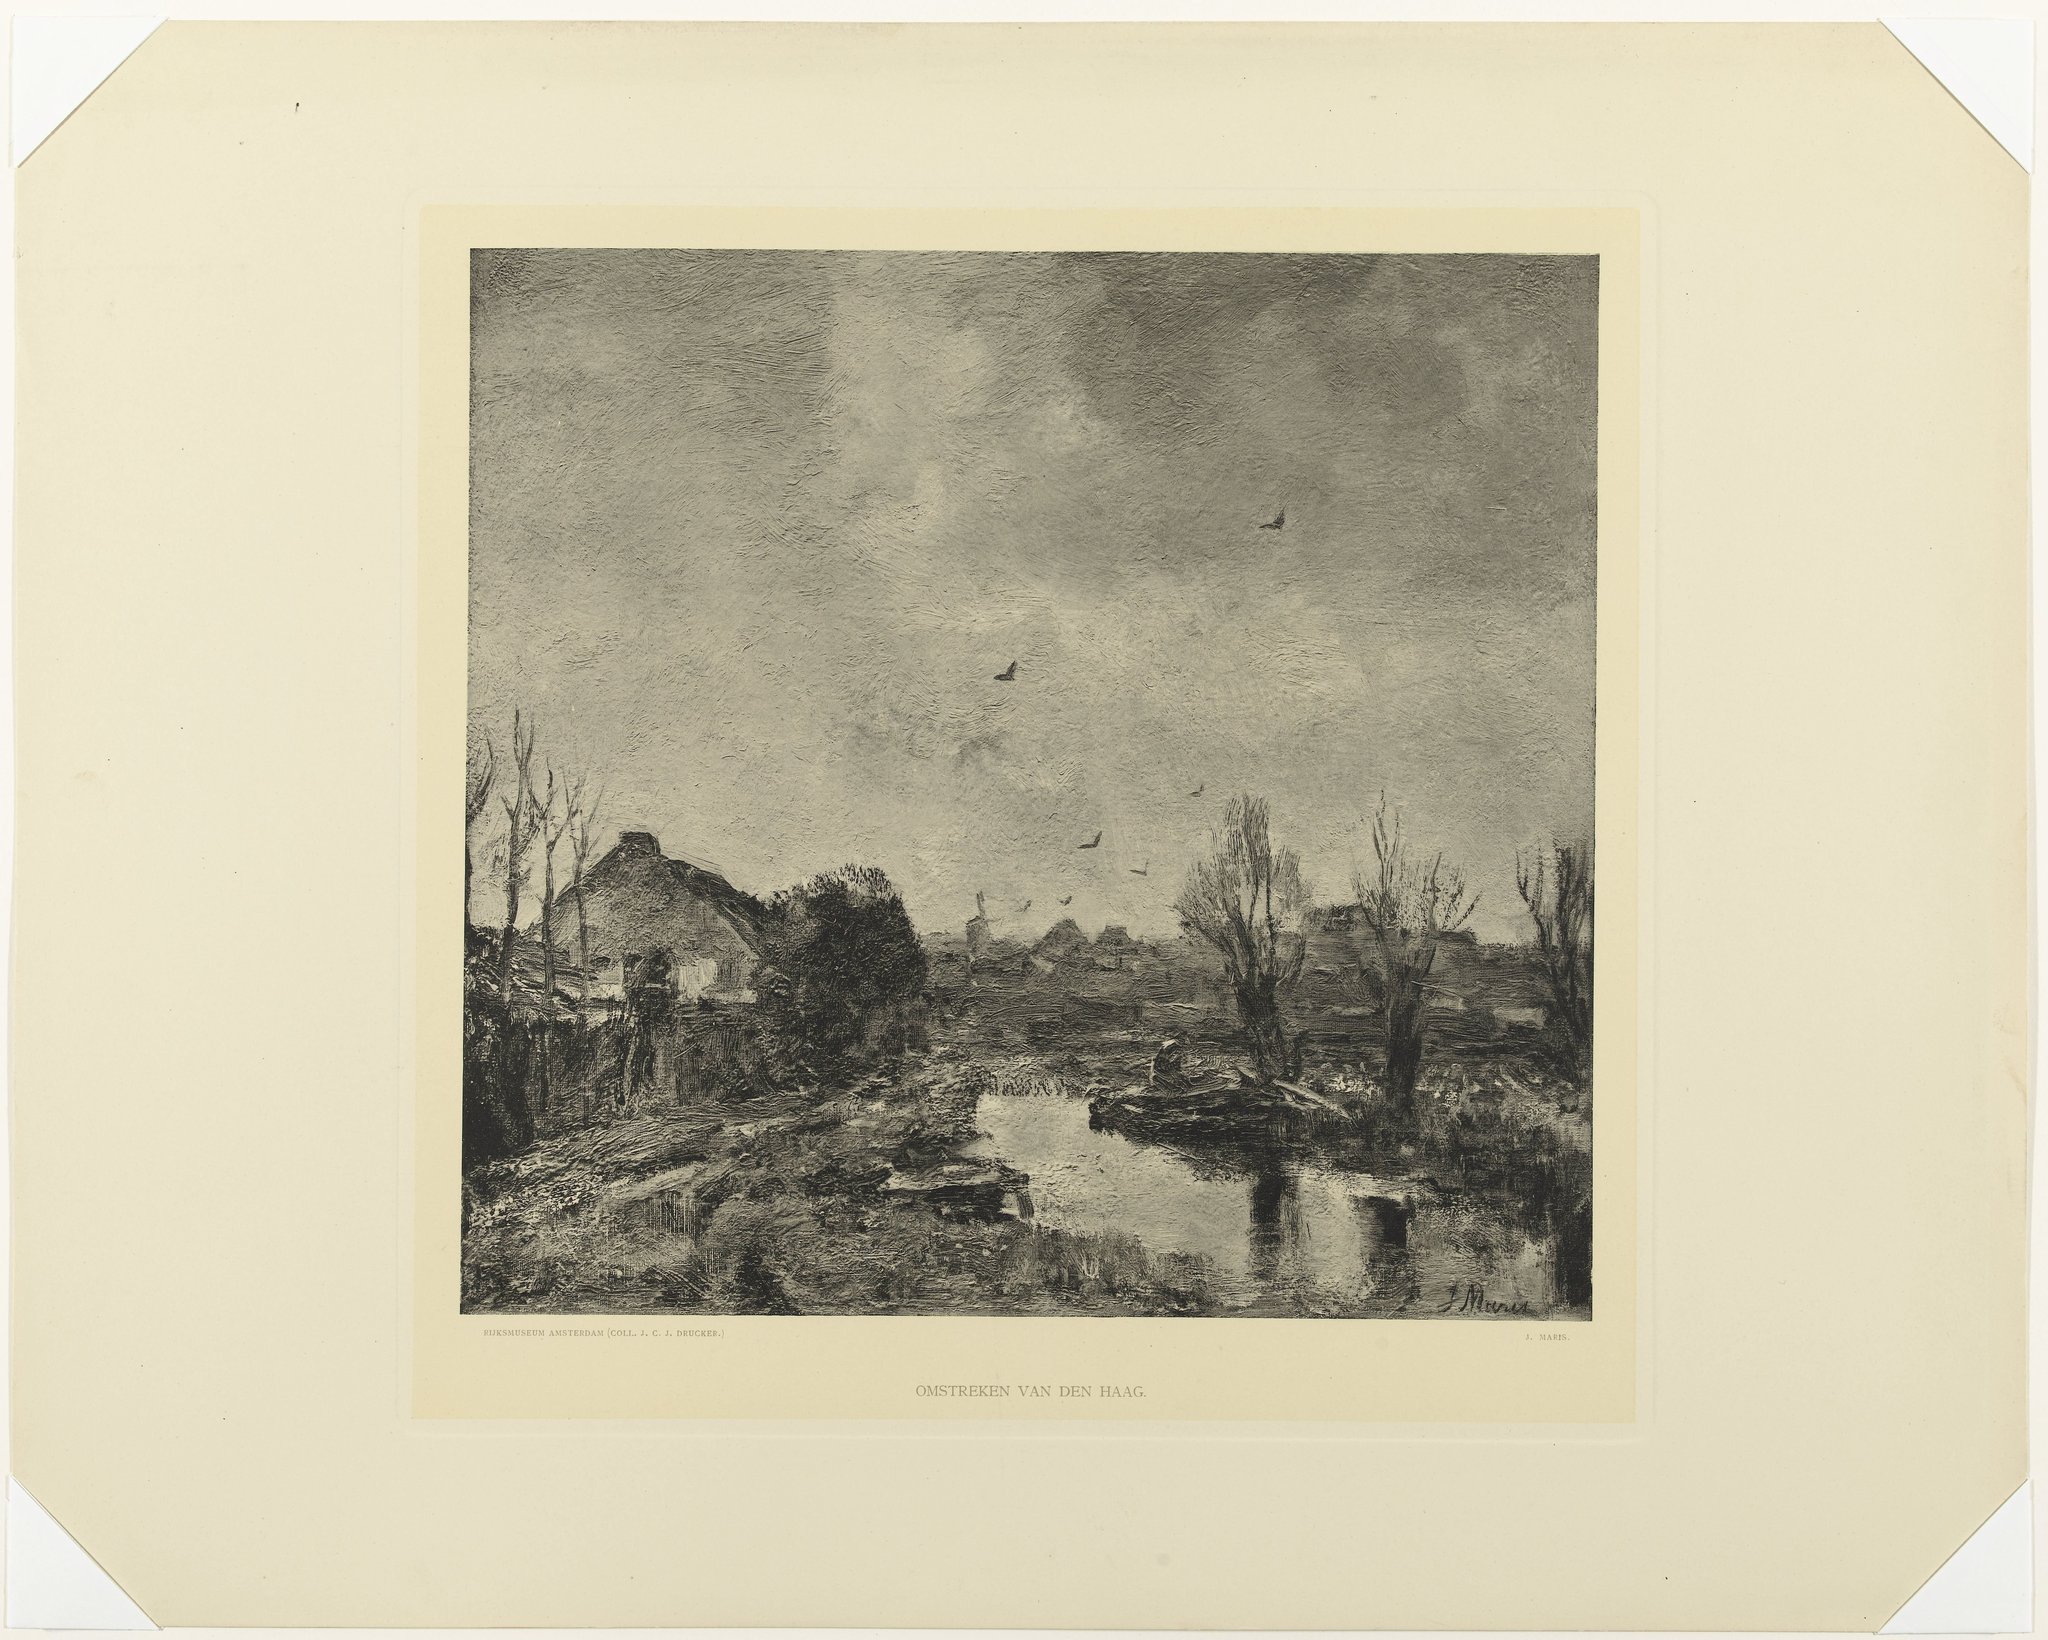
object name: fotomechanisch procedé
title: Landschap in de omgeving van Den Haag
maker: Anonymous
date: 1903-1920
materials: paper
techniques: photograph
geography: netherlands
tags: picture, painting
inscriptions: caption: ‘Rijksmuseum Amsterdam (coll. J.C.J. Drucker.)’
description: Foto-reproductie van schilderij Landschap in de omgeving van Den Haag door Jacob Maris